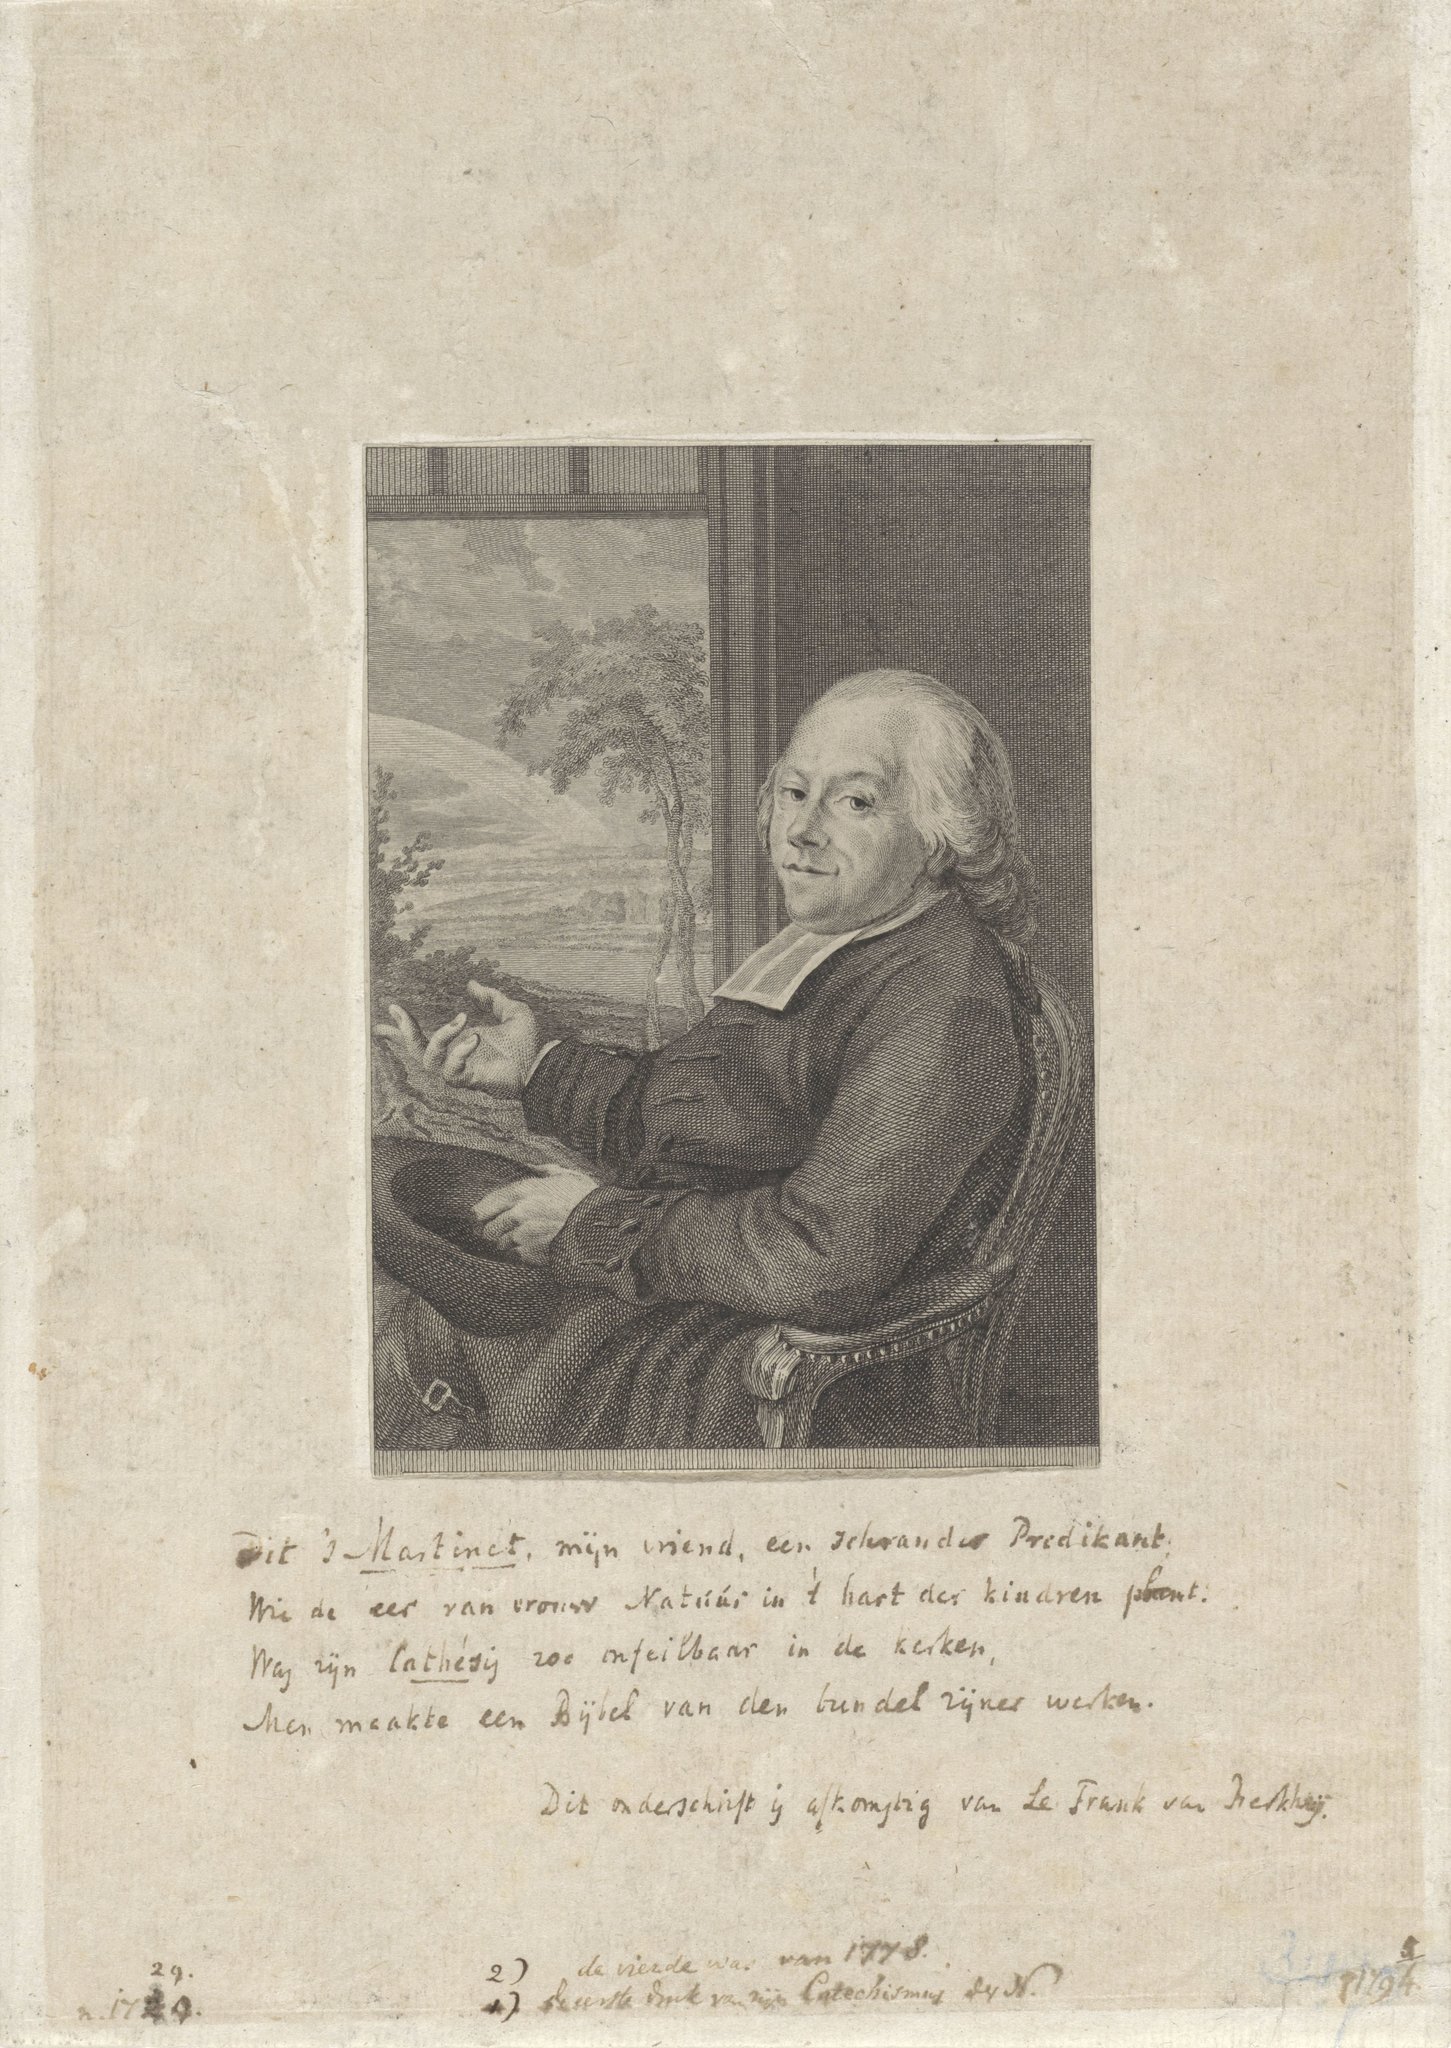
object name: print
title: Portret van Joannes Florentius Martinet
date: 1778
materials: paper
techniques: etching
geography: amsterdam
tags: amsterdam, joannes florentius martinet, open window, chair, rainbow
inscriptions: collector's mark: Lugt 2228, poem: ‘dit is Martinet, mijn vriend, een [...] Predikant/ Wie de eer van vrouw Natuur in het hart der kindren [...]/ Mag zijn Cathesij zoo onfeilbaar in de kerken,/ Men maakte een Bijbel van den bundel zijner werken. / Dit onderschrift is afkomstig van Le Frank van Berkheij.’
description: Portret van Joannes Florentius Martinet, predikant en pensionaris van Den Bosch. Hij zit met zijn hoed in de hand op een stoel bij een raam, waardoor een landschap met een regenboog zichtbaar is.